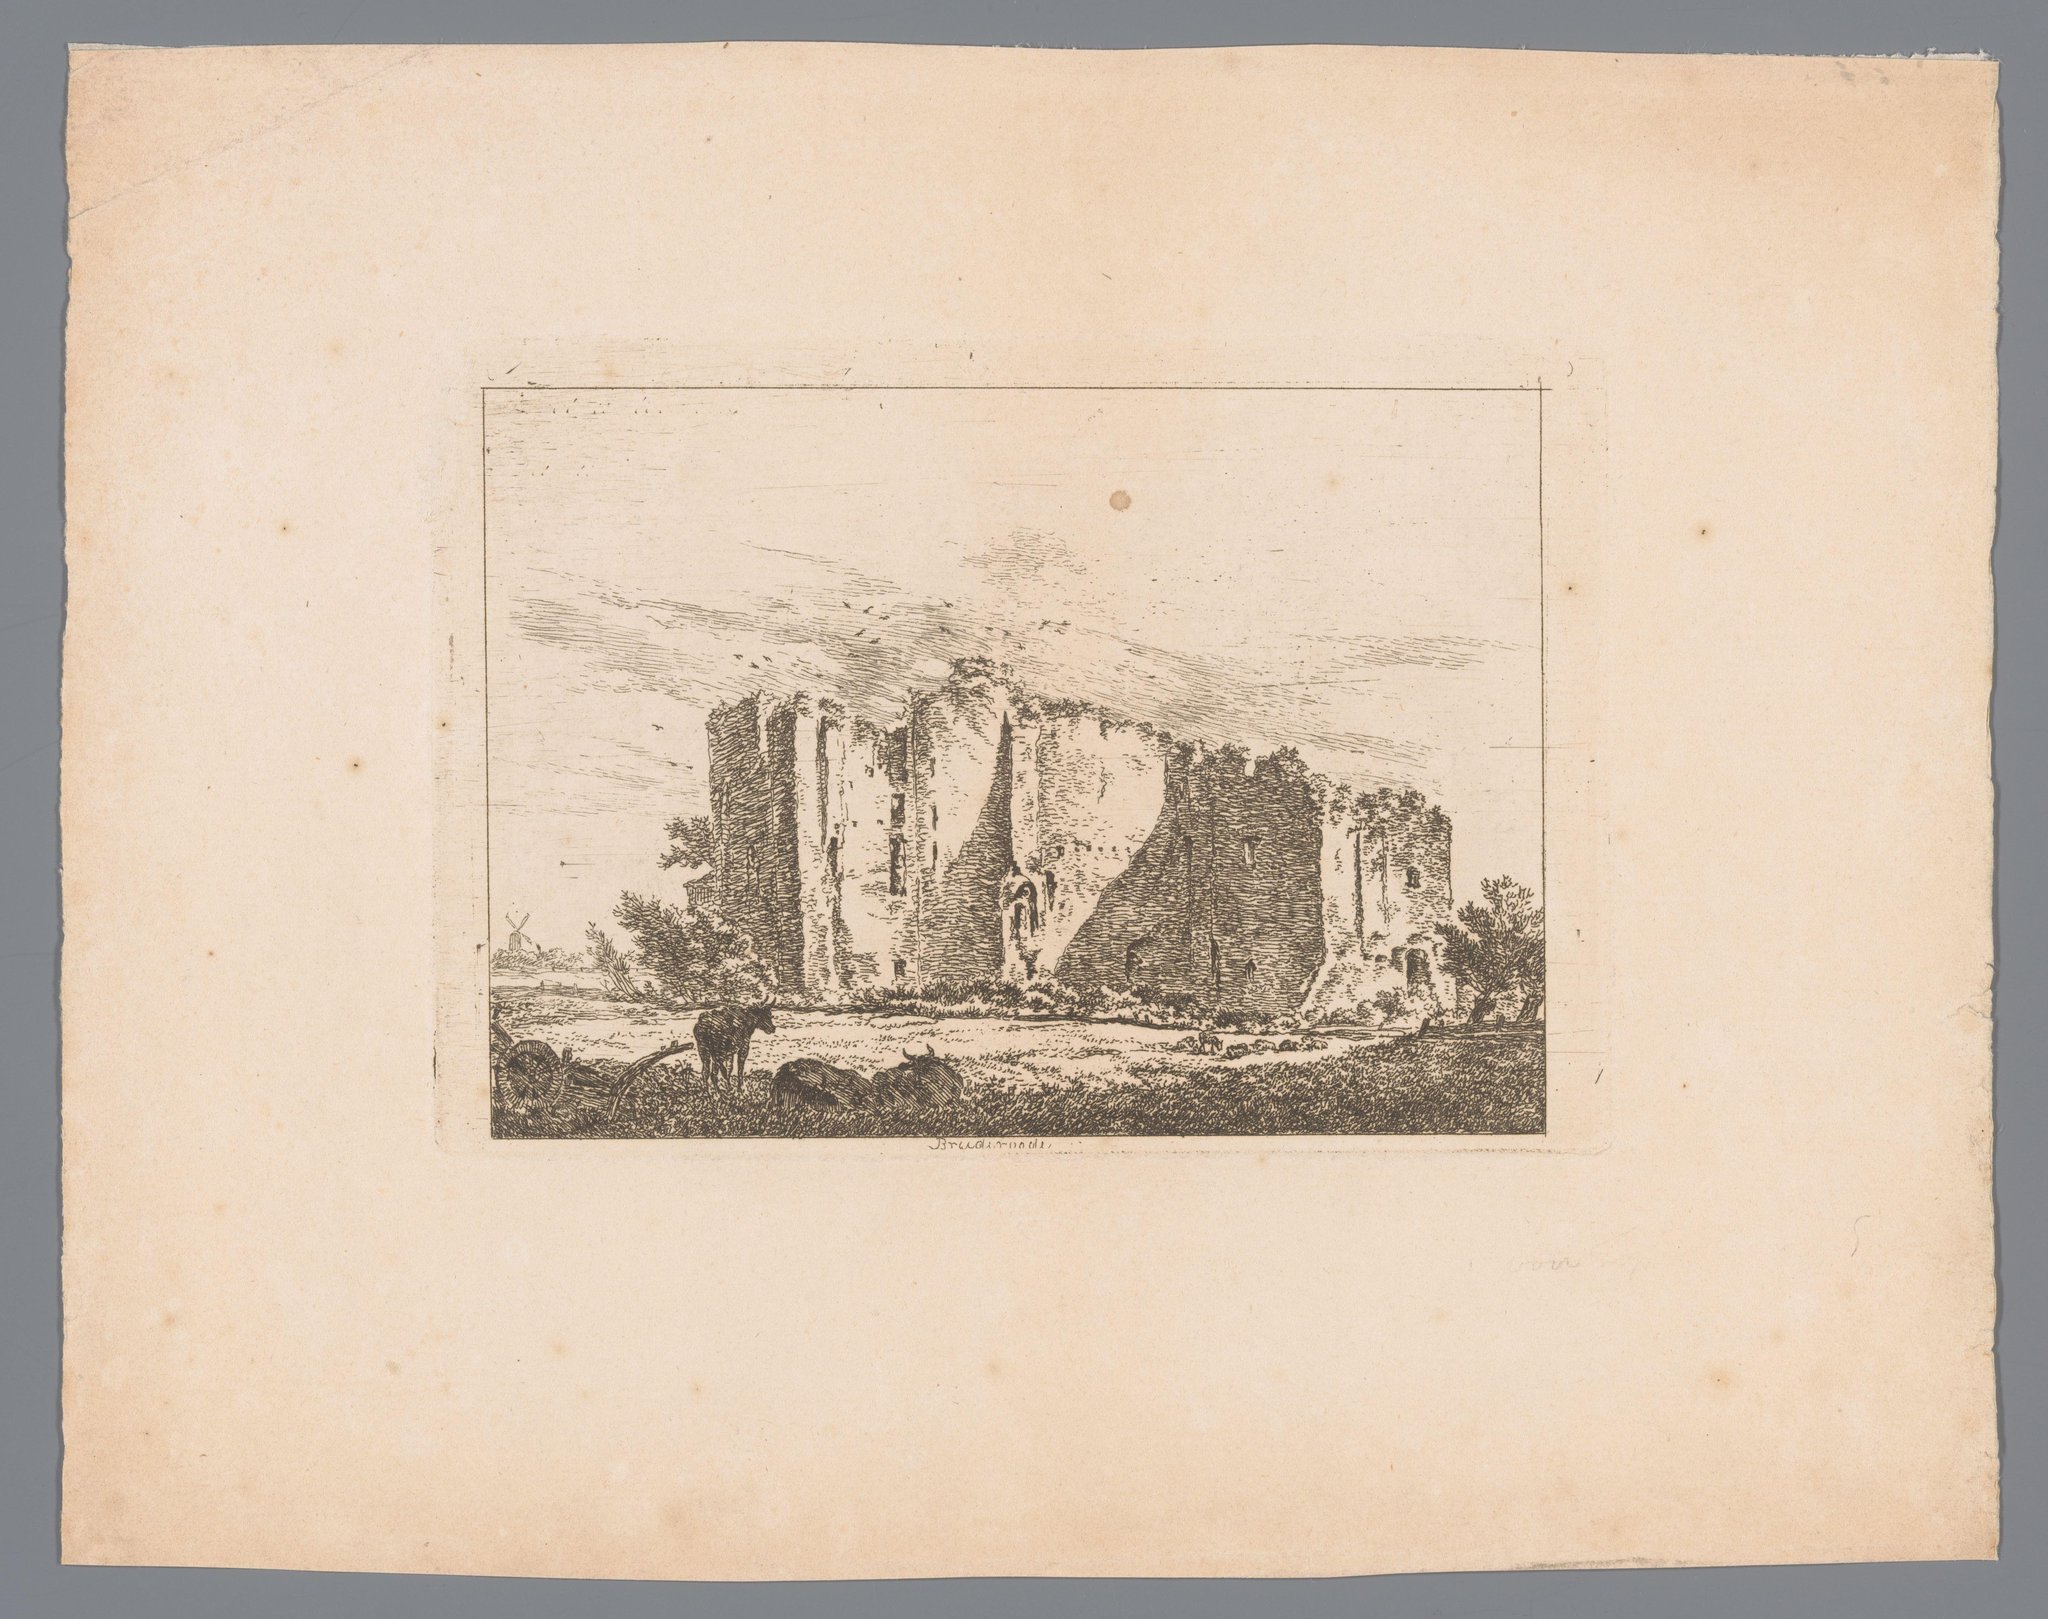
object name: print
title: Breederoode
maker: hermanus van brussel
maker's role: draughtsman, print maker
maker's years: 1763-1815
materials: paper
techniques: etching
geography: netherlands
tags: landscapes in the temperate zone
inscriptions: collector's mark: Lugt 2233